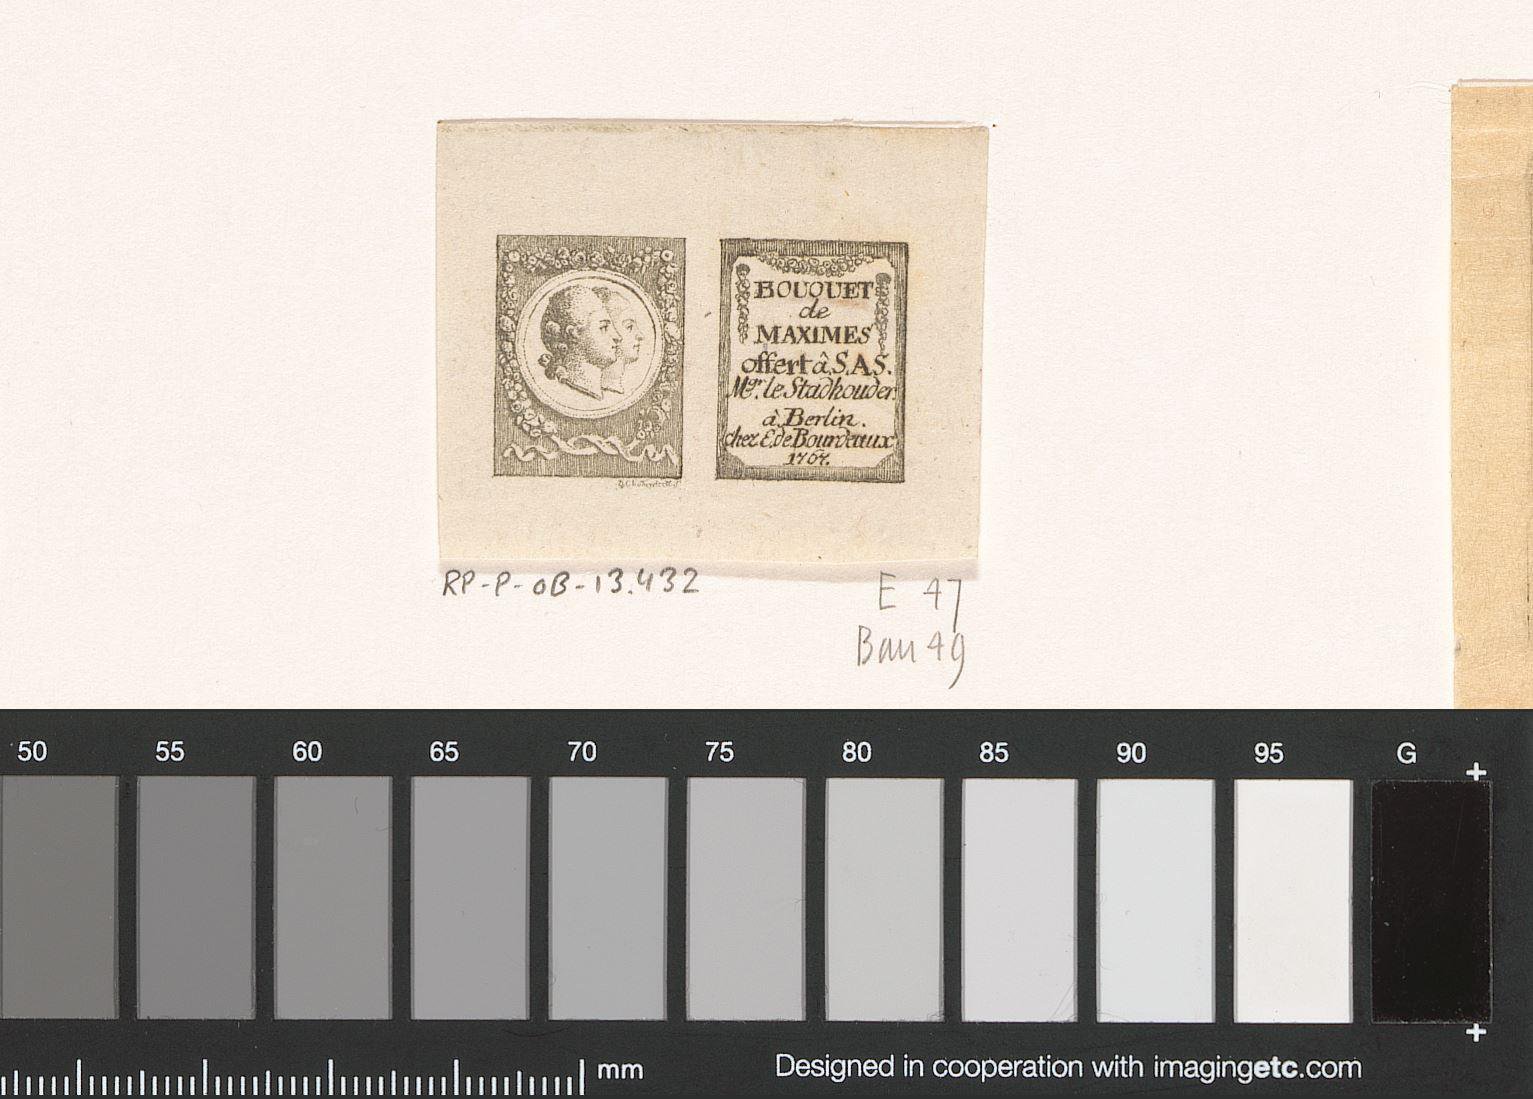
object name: print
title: Portretten van Willem V van Oranje en Wilhelmina van Pruisen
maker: daniel nikolaus chodowiecki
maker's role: draughtsman, print maker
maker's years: 1726-1801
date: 1767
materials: paper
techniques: etching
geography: berlin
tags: the hague, william v (prince of orange), berlin, painter, draughtsman, wilhelmina of prussia (princess of orange), historical persons - bb - woman, historical persons (portraits and scenes from the life)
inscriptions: collector's mark: Lugt 240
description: Deze prent is ook gebruikt als titelpagina voor een tekst van Formey getiteld 'Bouquet de Maximes'. Ter ere van het huwelijk van Willem V en Wilhelmina van Pruisen in 1767 gaf de Berlijnse boekhandelaar E. de Bourdeaux deze tekst uit in een almanak die een hanger gedragen kon worden.